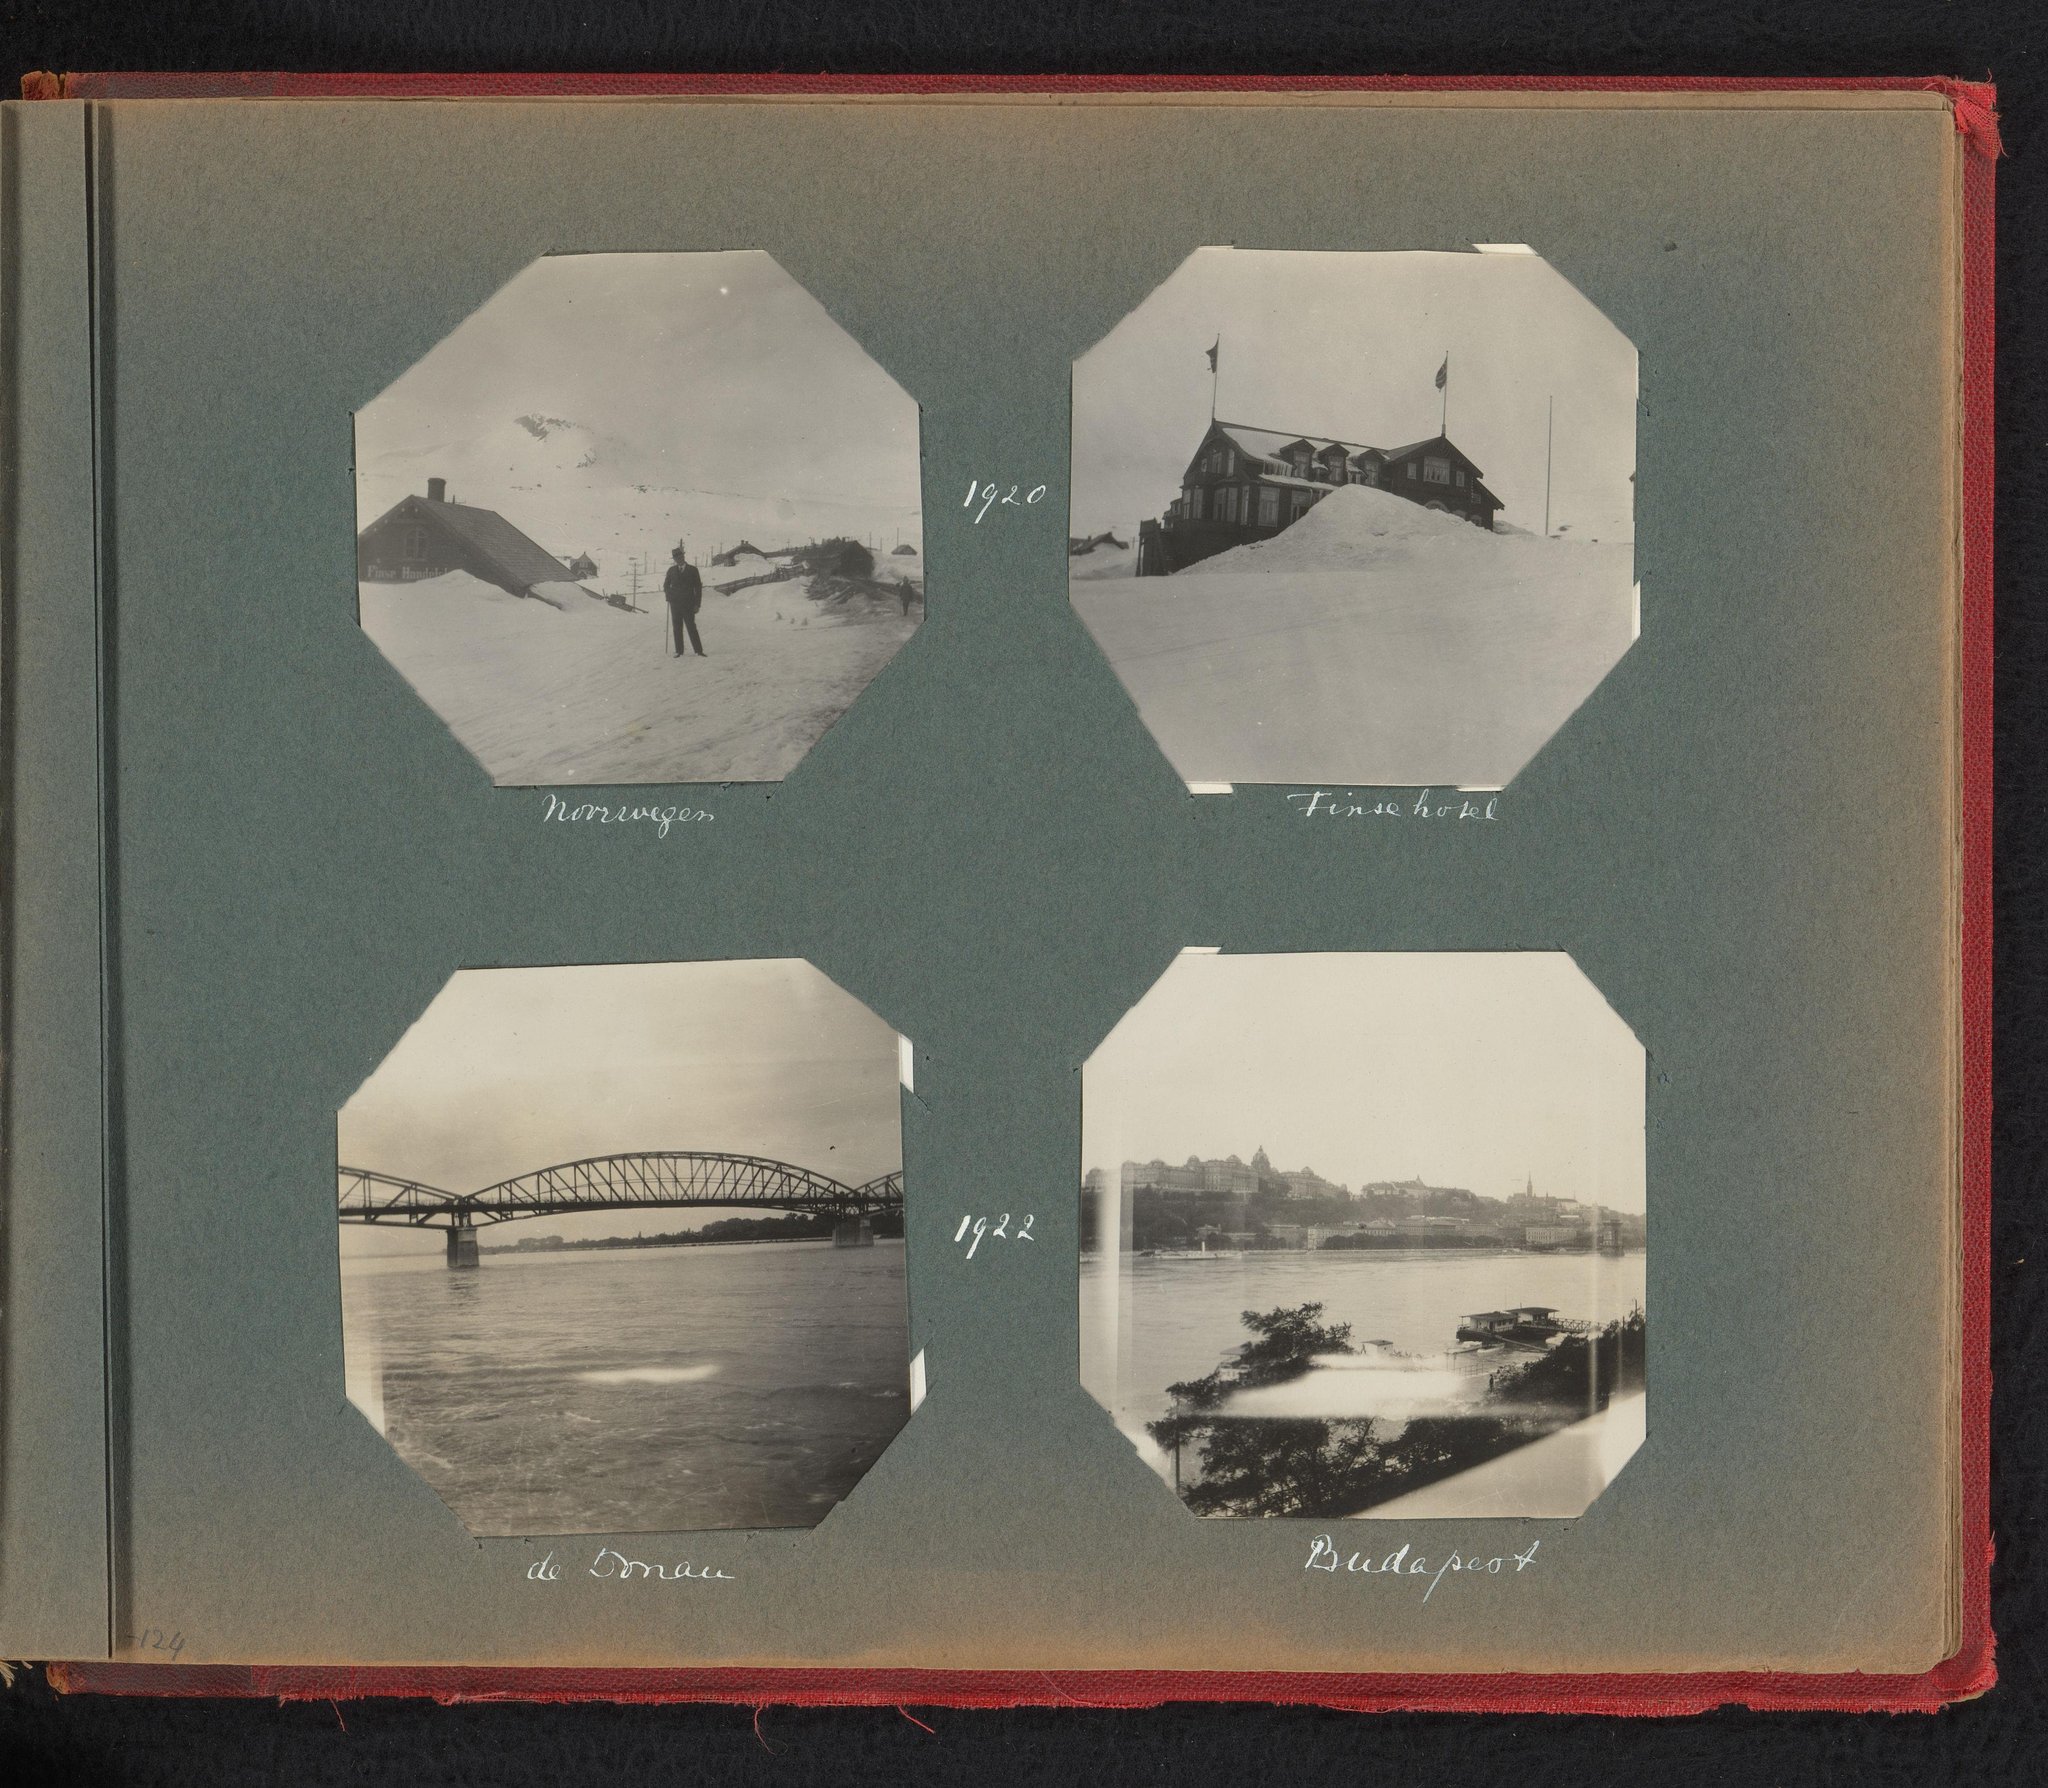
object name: photograph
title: Joan Boelen in Noorwegen en Finland, en twee gezichten op de Donau in Boedapest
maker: charlotte alida boelen-matthes (lot)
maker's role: amateurfotograaf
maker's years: 1889-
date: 1920-1922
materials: paper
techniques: gelatin silver print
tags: joan gerard boelen, landscape with bridge, viaduct or aqueduct, snow, mountains, norway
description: Deze foto's zijn onderdeel van een album.